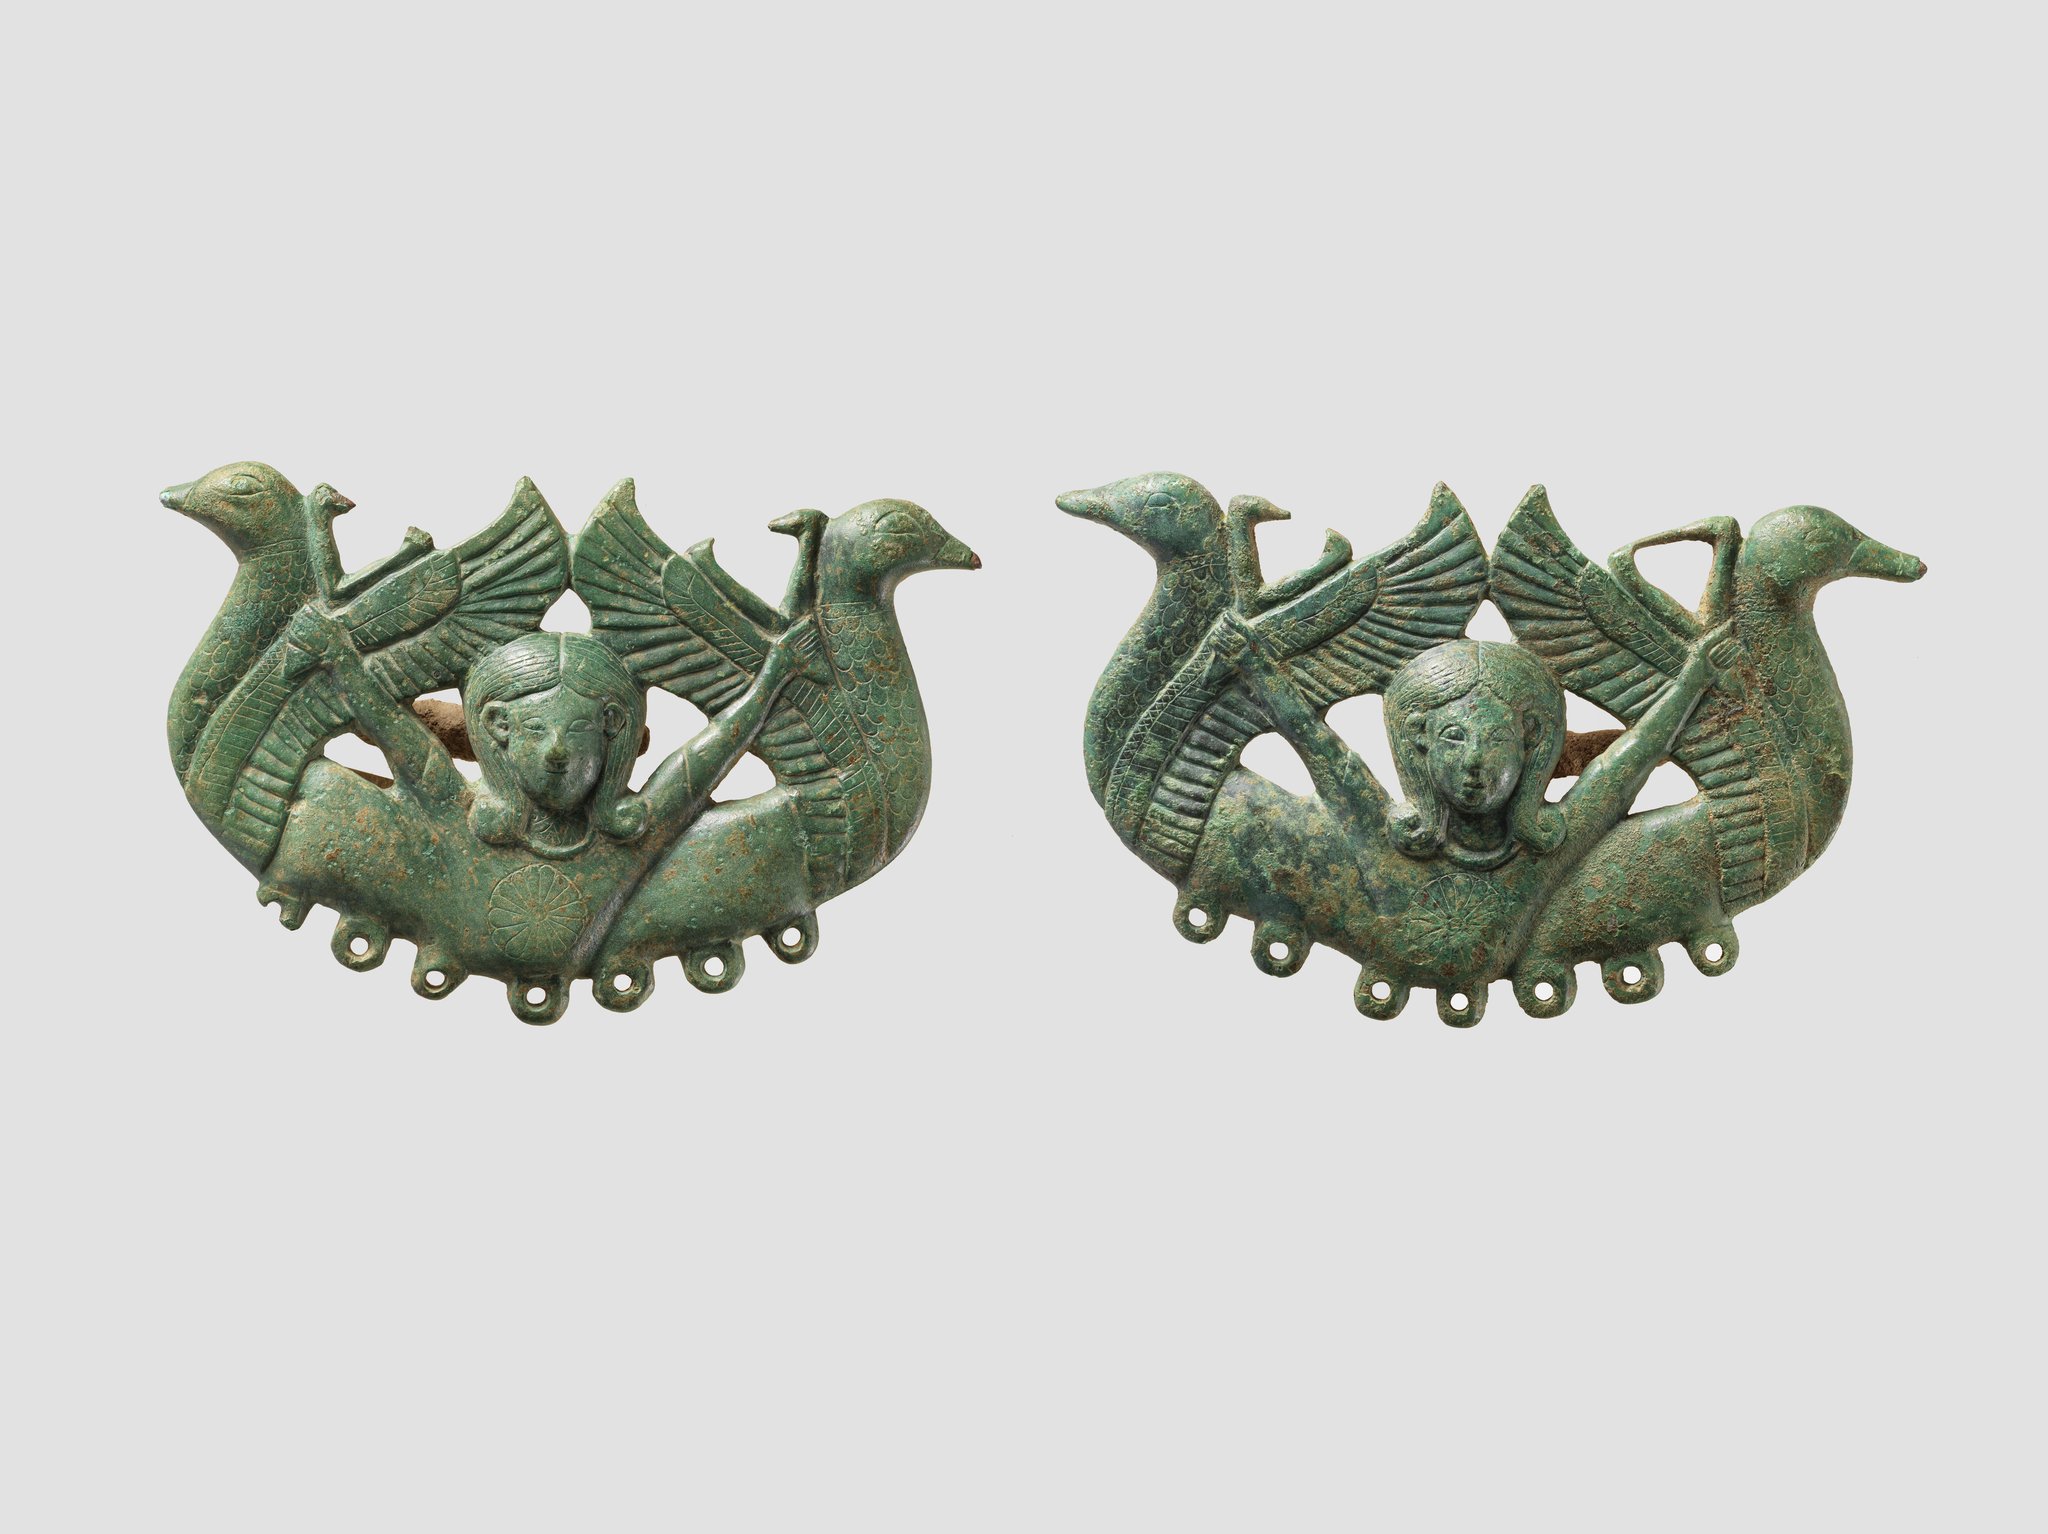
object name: harness or bridle fitting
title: Harness or bridle fitting (?) in the form of a mistress of animals and waterbirds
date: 700-501 BCE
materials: bronze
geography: iberian peninsula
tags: birds,women